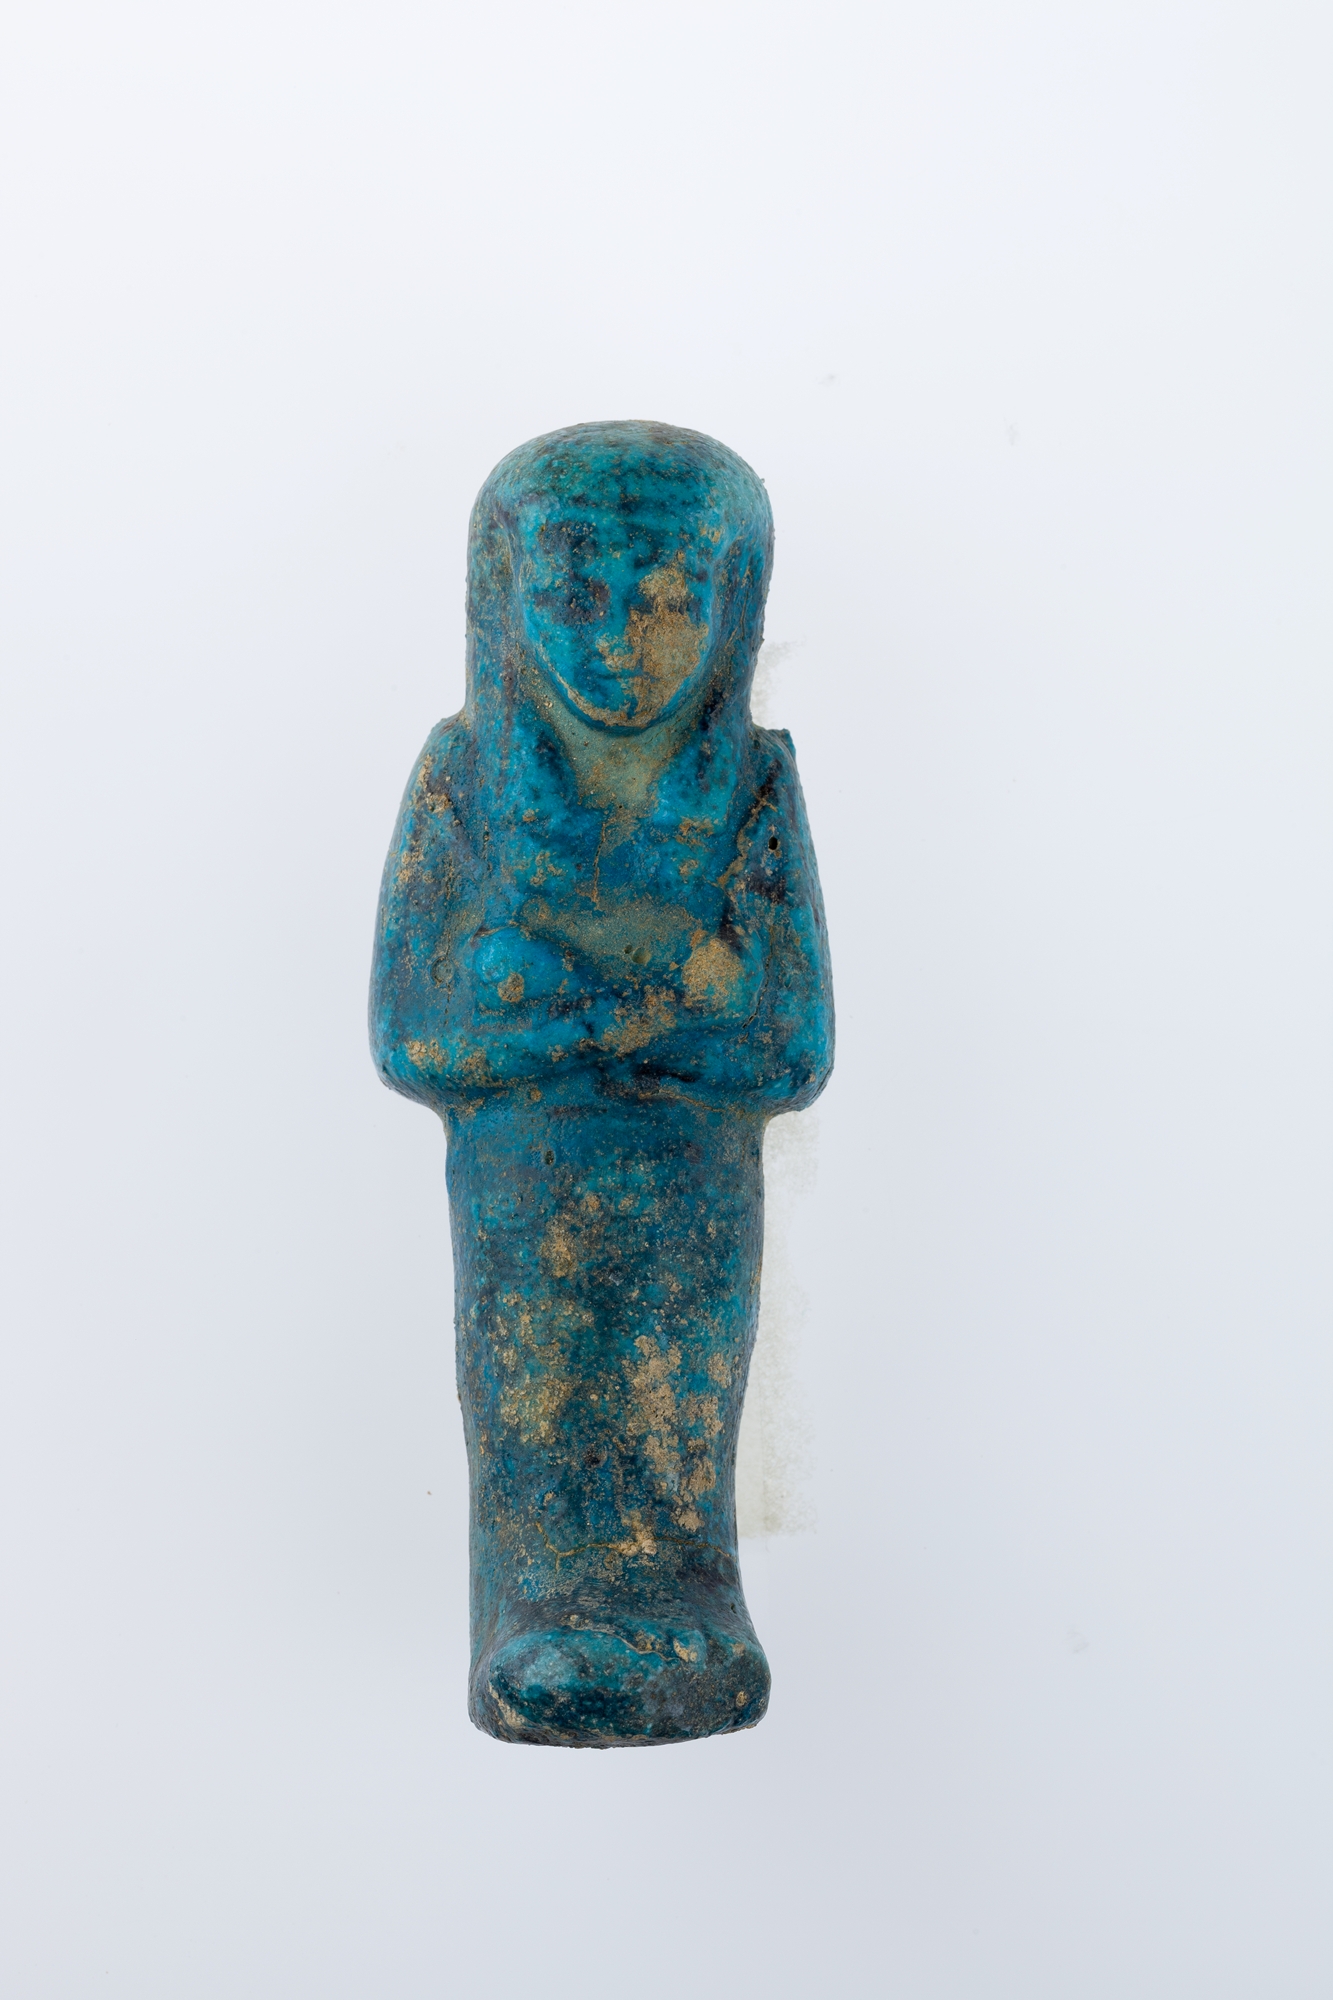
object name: shabti, henettawy c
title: Worker Shabti of Henettawy (C), Daughter of Isetemkheb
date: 990-970 BCE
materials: faience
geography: egypt